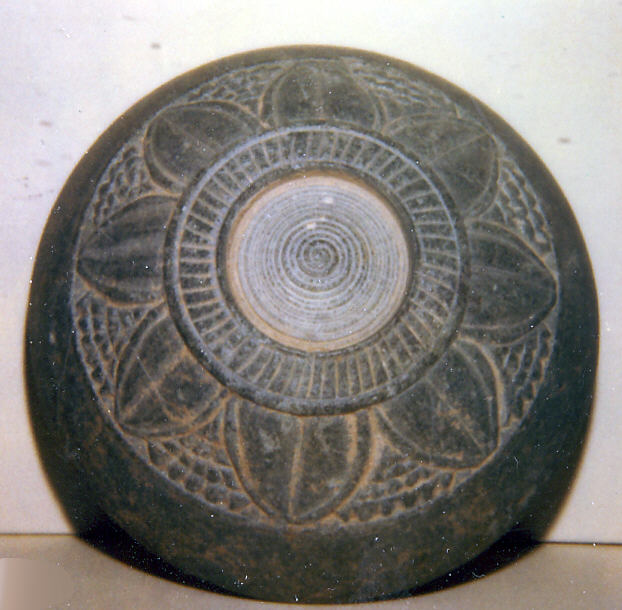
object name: lid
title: Lid of a Relic Casket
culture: gandhara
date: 1-100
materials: stone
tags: gandhara